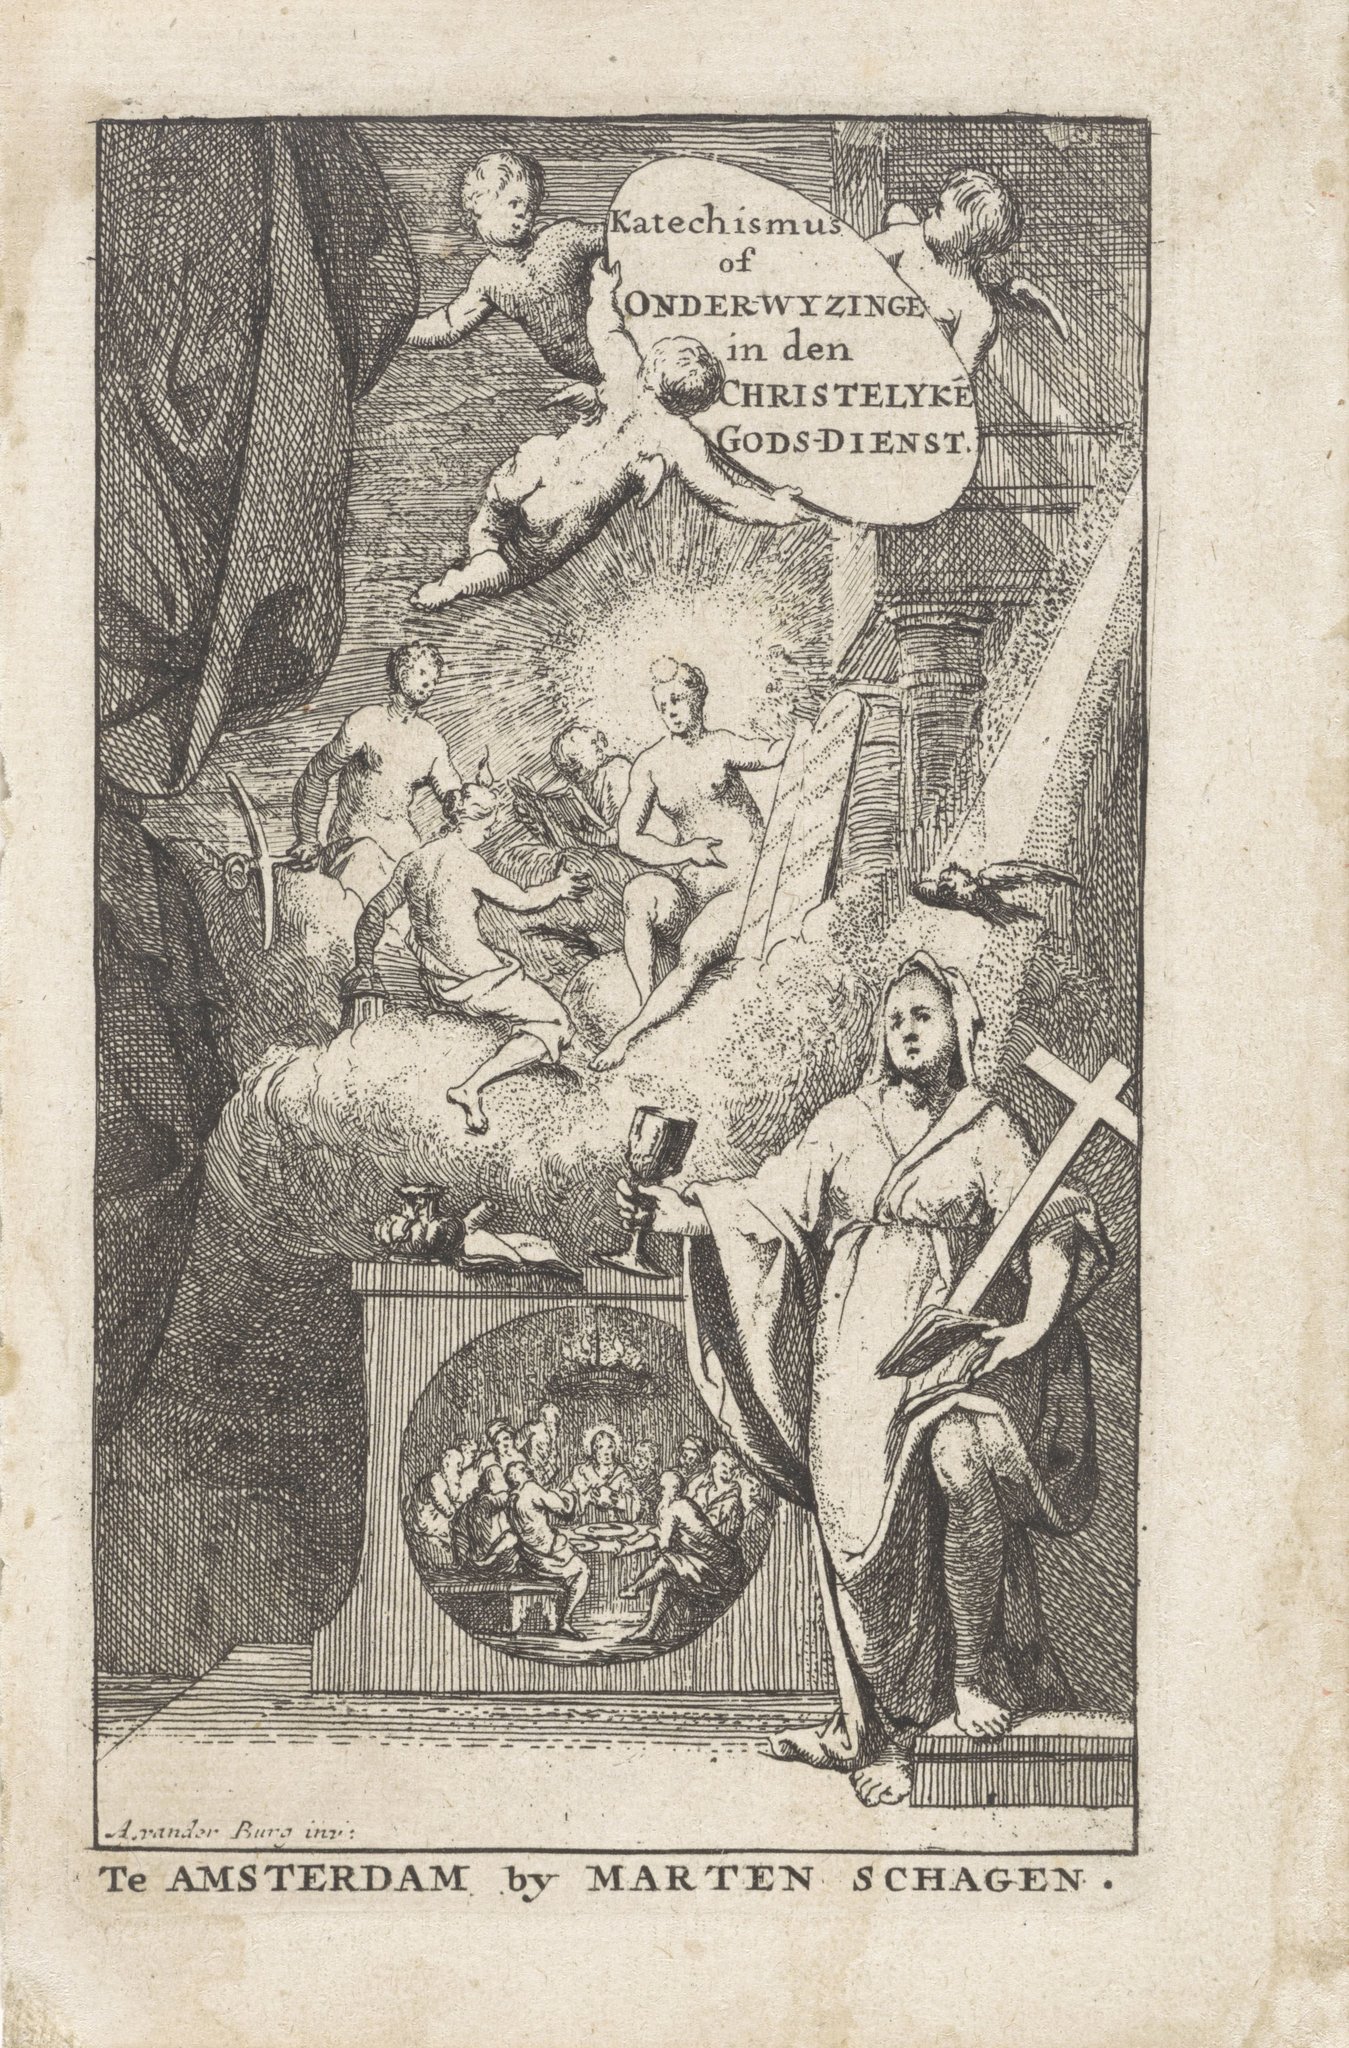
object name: titelblad, titelpagina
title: Allegorie op het christelijke geloof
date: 1728-1732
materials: paper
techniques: etching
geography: amsterdam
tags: catechism, faith, 'fides'; 'fede', 'fede catholica', 'fede christiana', 'fede christiana catholica' (ripa) ~ one of the three theological virtues, last supper (in general) (matthew 26:21-35; mark 14:18-31; luke 22:3, 22:15-23; john 13:21-38)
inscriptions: collector's mark: Lugt 2228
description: Allegorie op het christelijke geloof. Rechts staat de personificatie van het Geloof. In haar linkerhand heeft ze een geschrift en een kruis en in haar rechterhand een miskelk. Boven haar de Heilige Geest in de gedaante van een duif. Achter haar een altaar met een voorstelling van het Laatste Avondmaal. Boven het altaar onderwijst de naakte personificatie van de catechismus (met hostie) de twee goddelijke deugden Hoop (met anker) en Liefde (met vlam). Achter haar zit nog een figuur met een geschrift op zijn schoot. Boven houden drie engelen de titel omhoog.